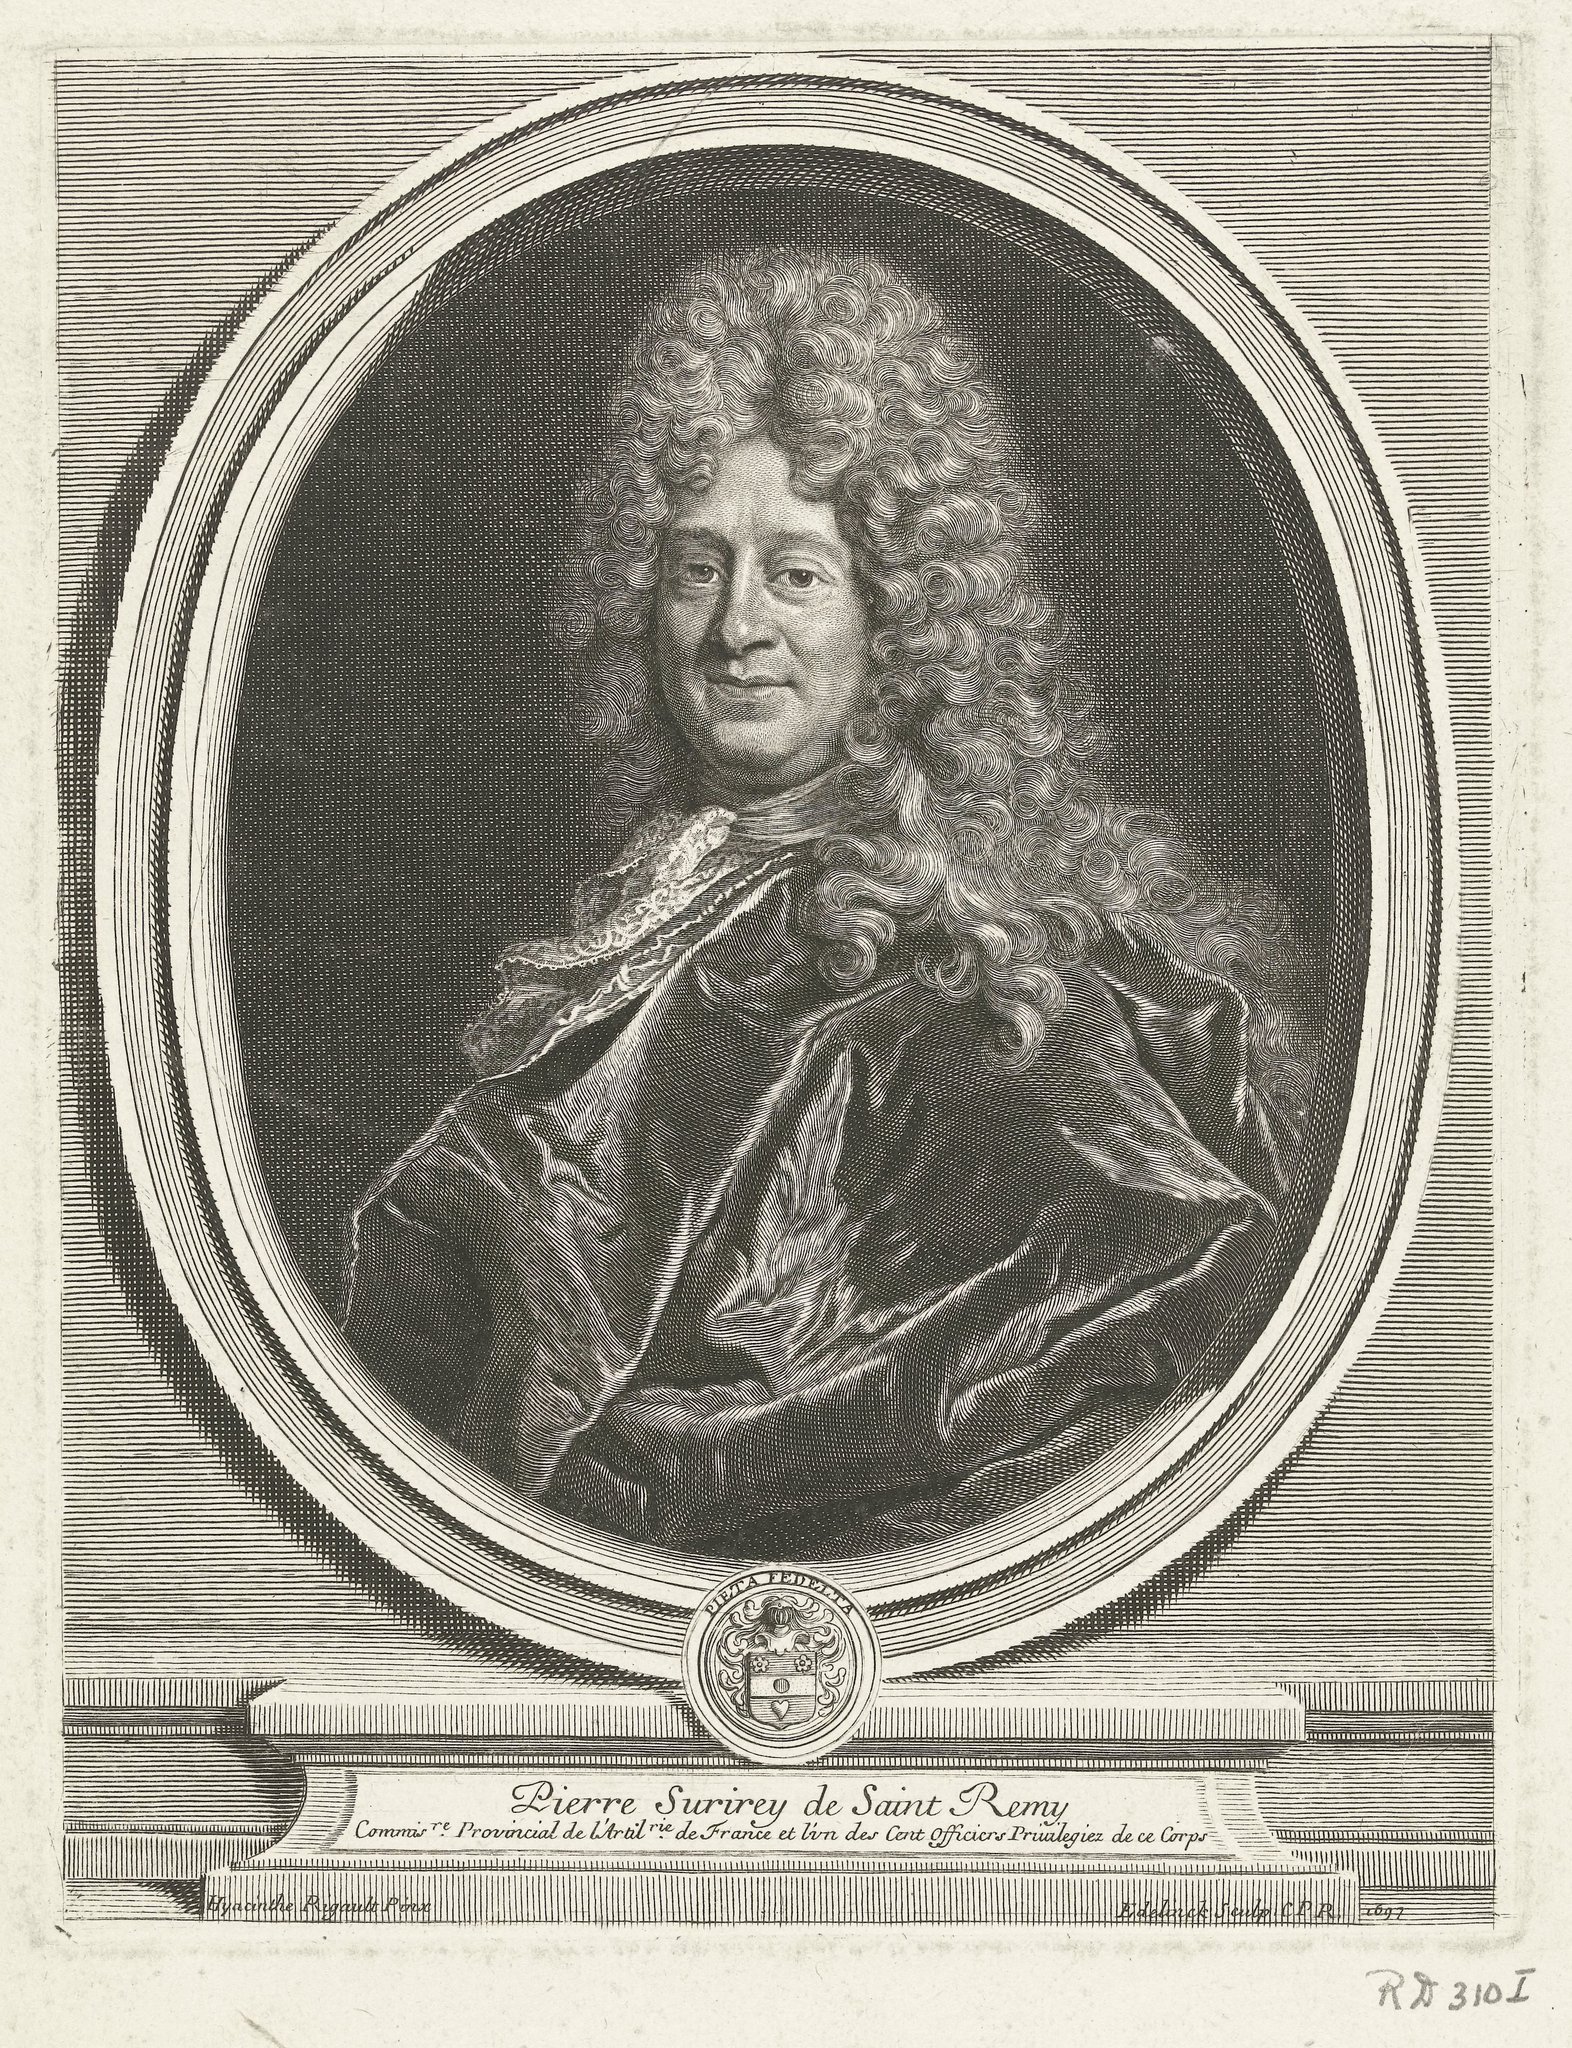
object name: print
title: Portret van Pierre Surirey de Saint Rémy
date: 1697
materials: paper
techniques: engraving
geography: paris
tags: luitenant, pierre surirey de saint rémy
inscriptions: inscription: ‘N. 366 uit De la Boists (?) Verk. te Leyden in Apr. 1767 f.-16-’, collector's mark: Lugt 2233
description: Portret van de Franse luitenant Pierre Surirey de Saint Rémy, afgebeeld in ovale omlijsting met wapen in rond medaillon.